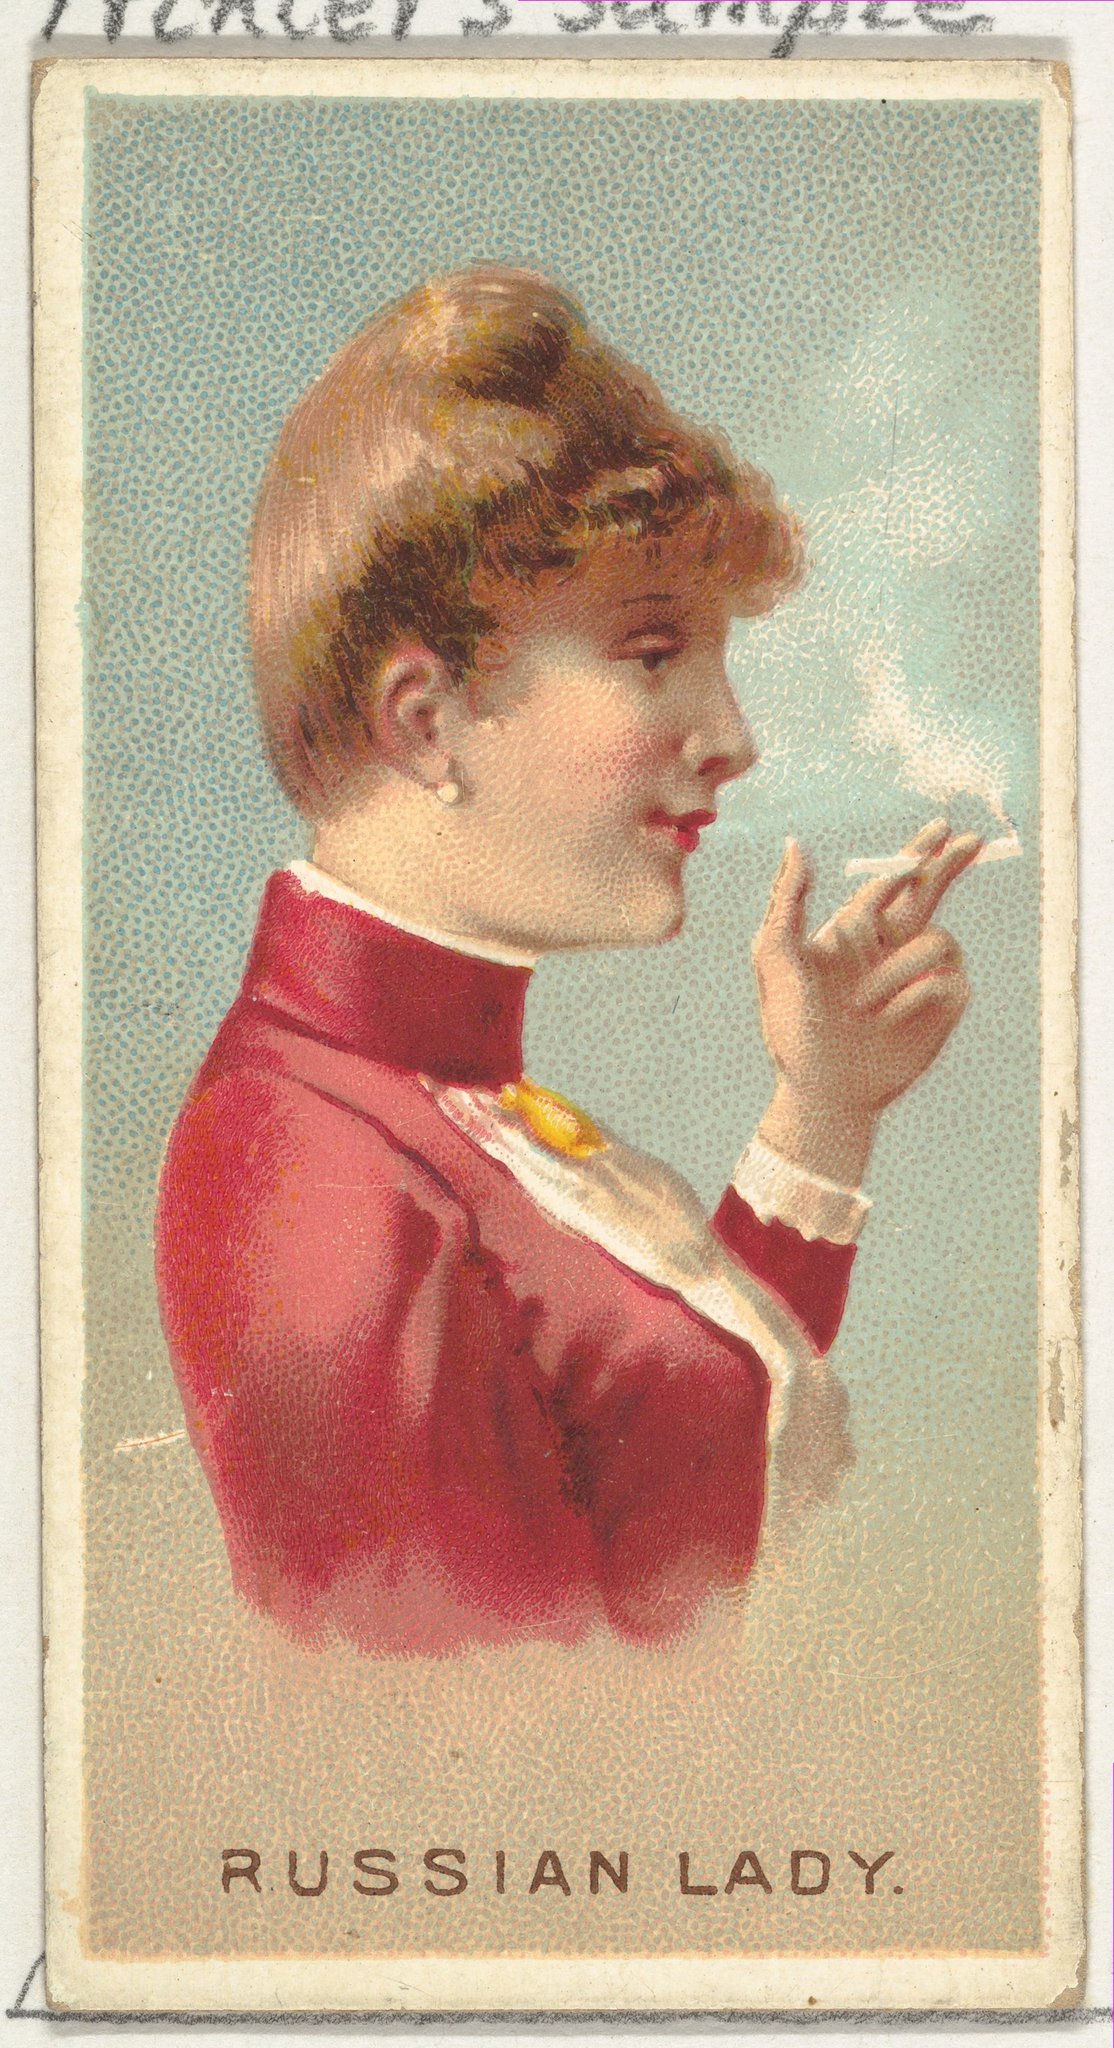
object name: print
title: Russian Lady, from World's Smokers series (N33) for Allen & Ginter Cigarettes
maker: allen & ginter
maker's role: publisher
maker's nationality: american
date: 1888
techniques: color lithograph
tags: profiles,women,smoking